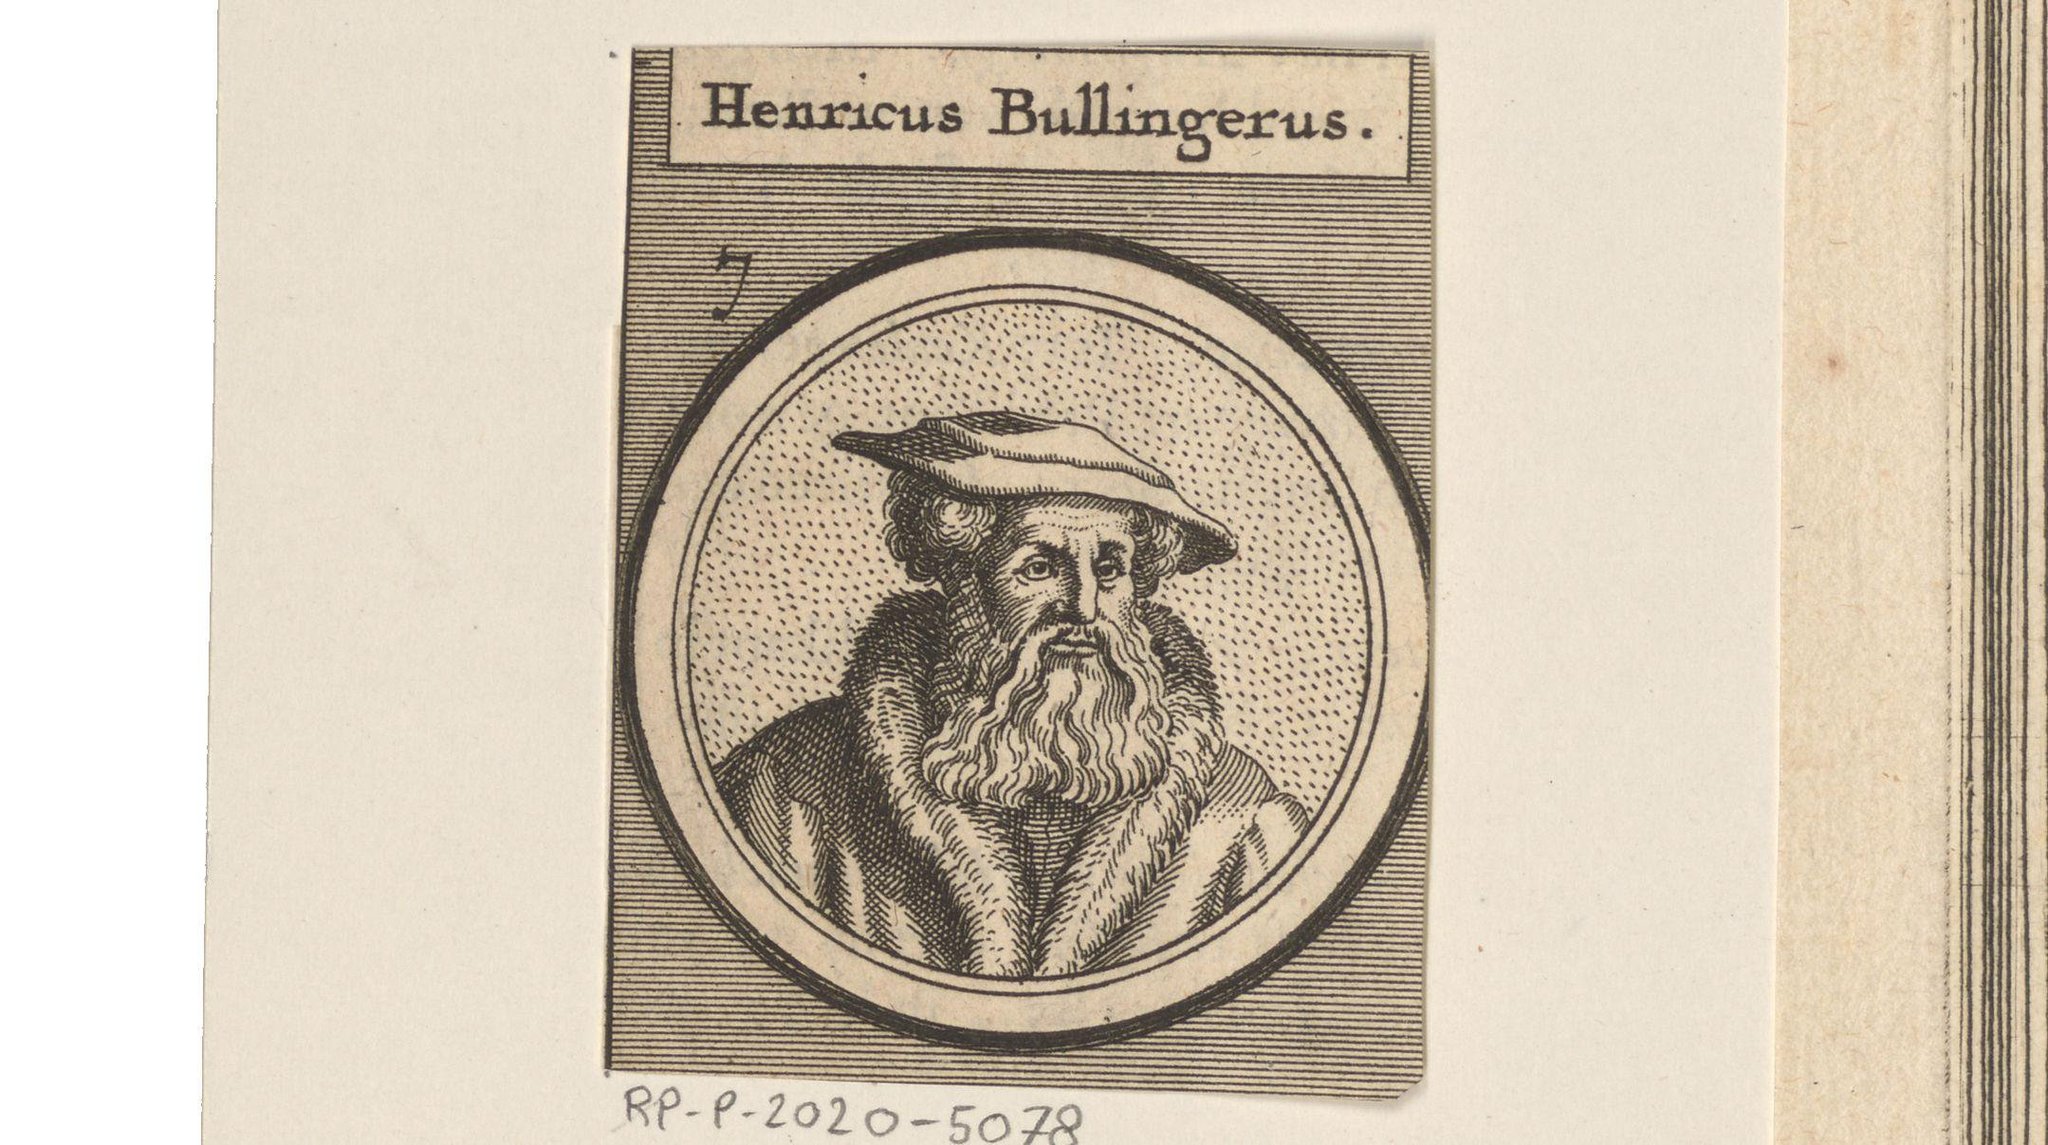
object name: book illustration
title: Portret van Johann Heinrich Bullinger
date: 1702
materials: paper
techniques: etching, letterpress printing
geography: leiden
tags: theologian, historical persons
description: Prent uit: Gottfried, Johann Ludwig. Vermeerderde en verbeterde historische kronyck, in vier stucken. Leiden: Pieter van der Aa, 1702. Prent voor het eerst gebruikt in de eerste editie van 1660. Ook gebruikt in latere edities van dit werk.